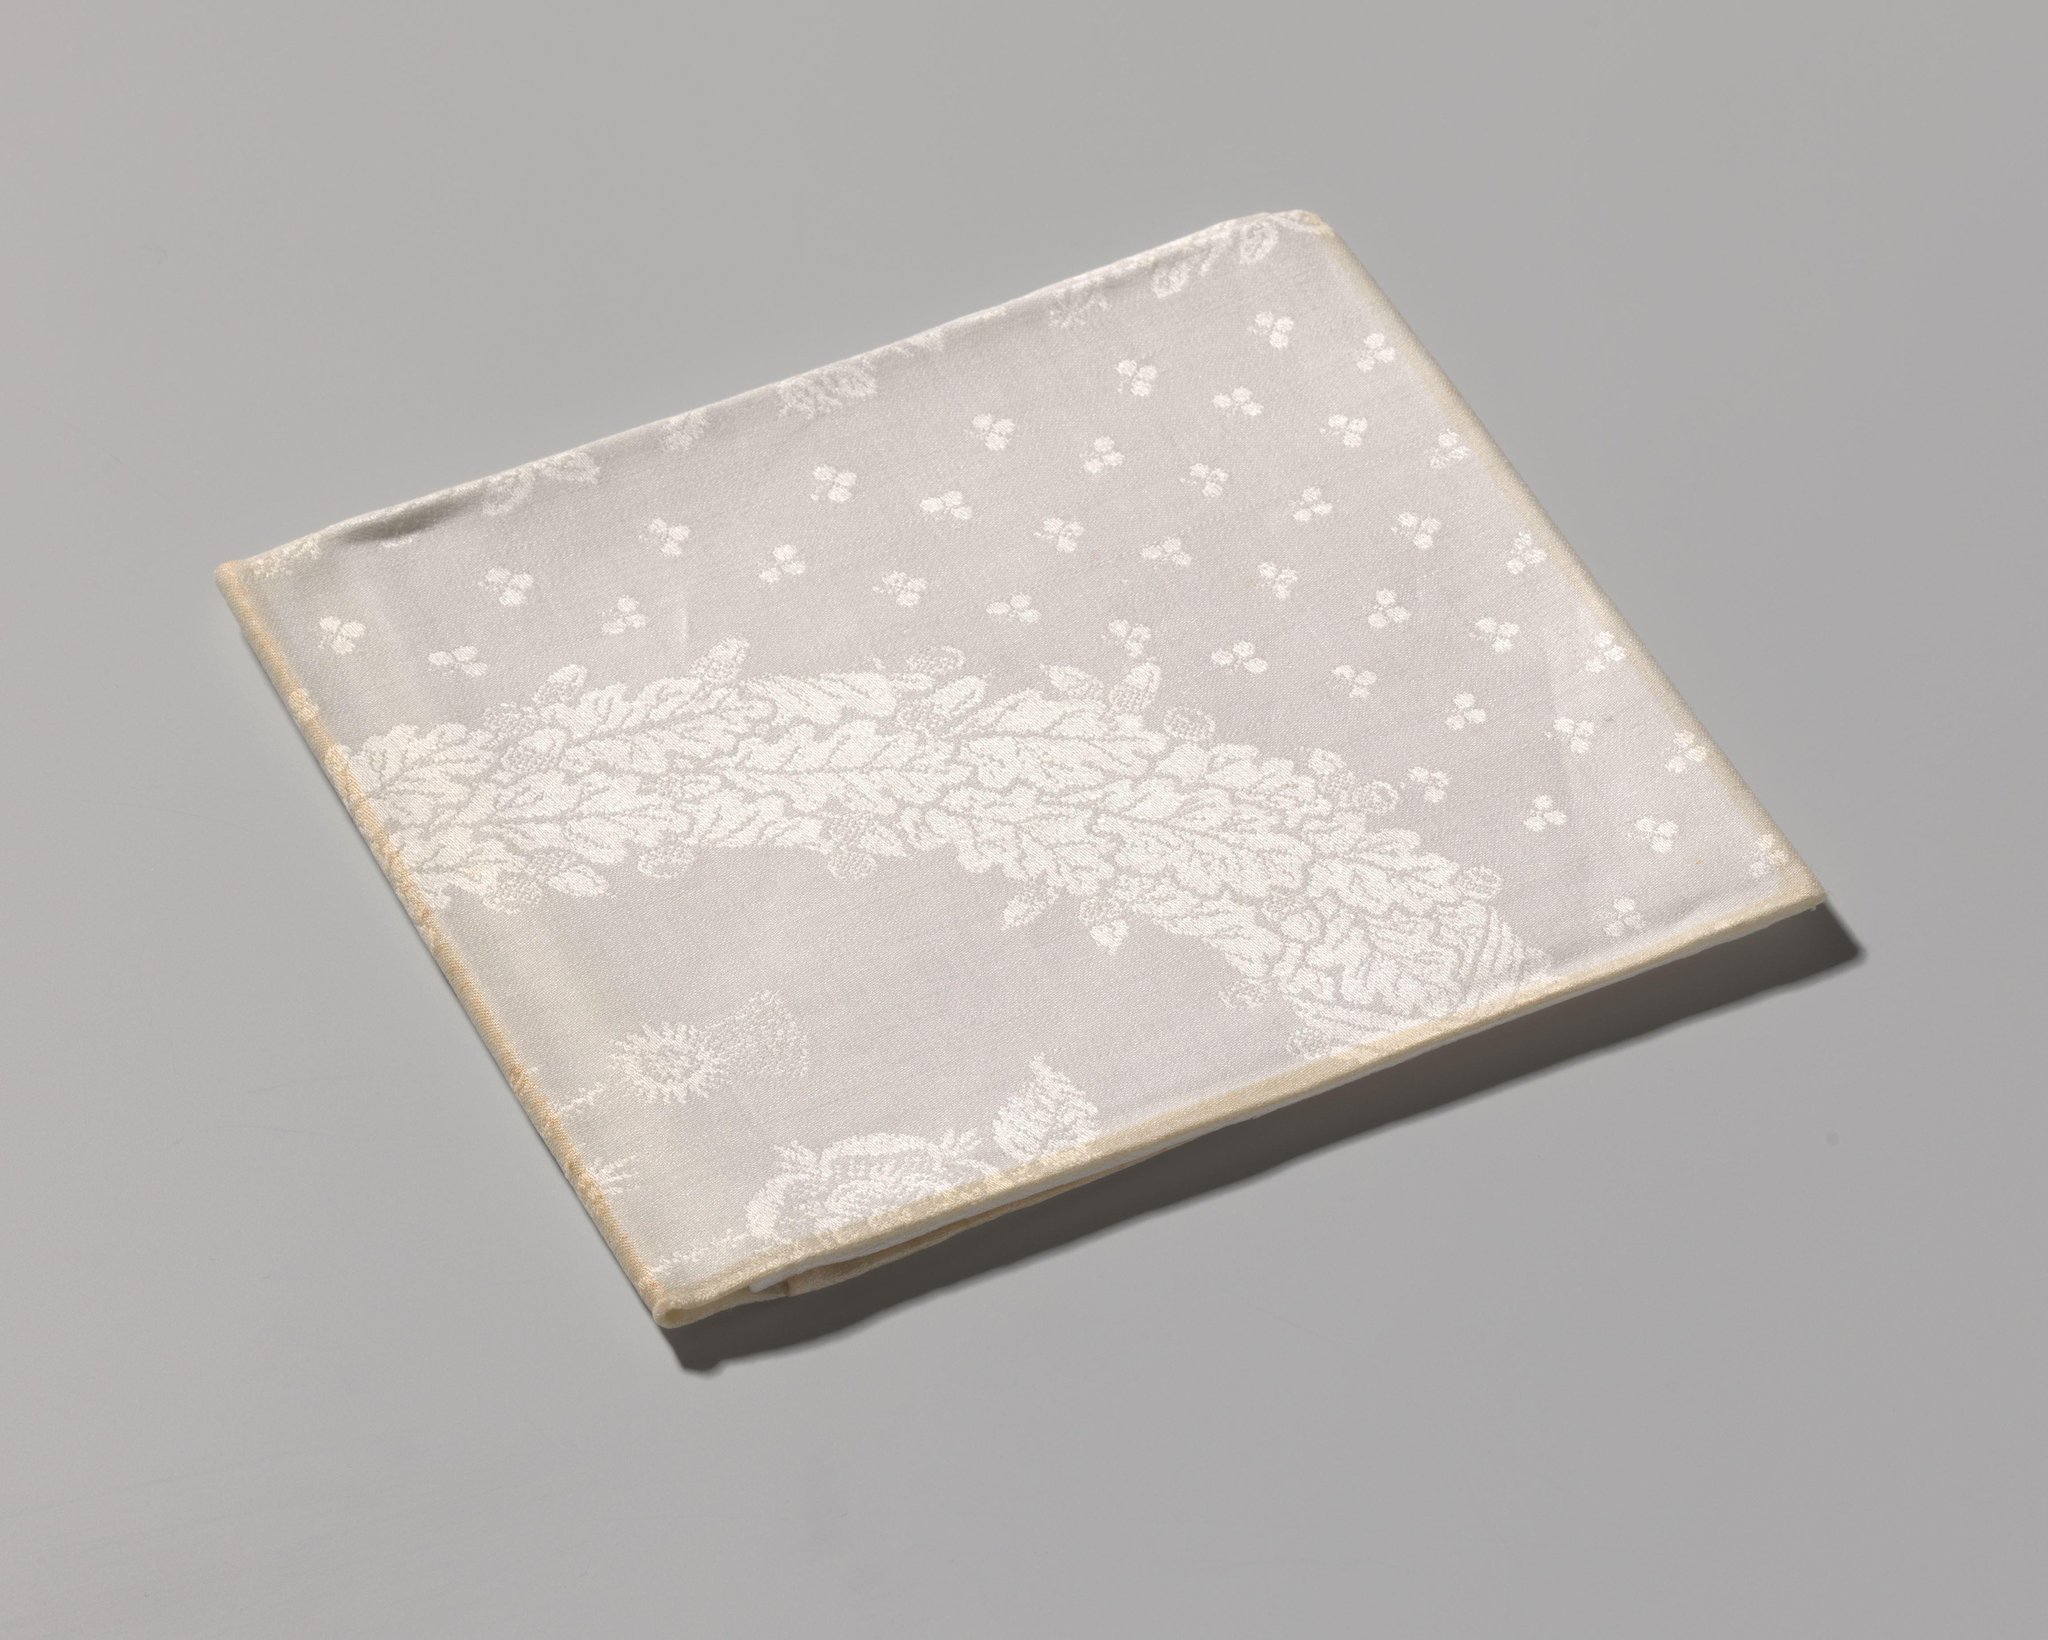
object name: napkin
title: Servet van wit linnendamast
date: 1890-1910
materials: linen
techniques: damask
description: Wit linnendamasten servet met een distel, roos en klaverblad binnen eikenkrans-patroon, merk MB 24.